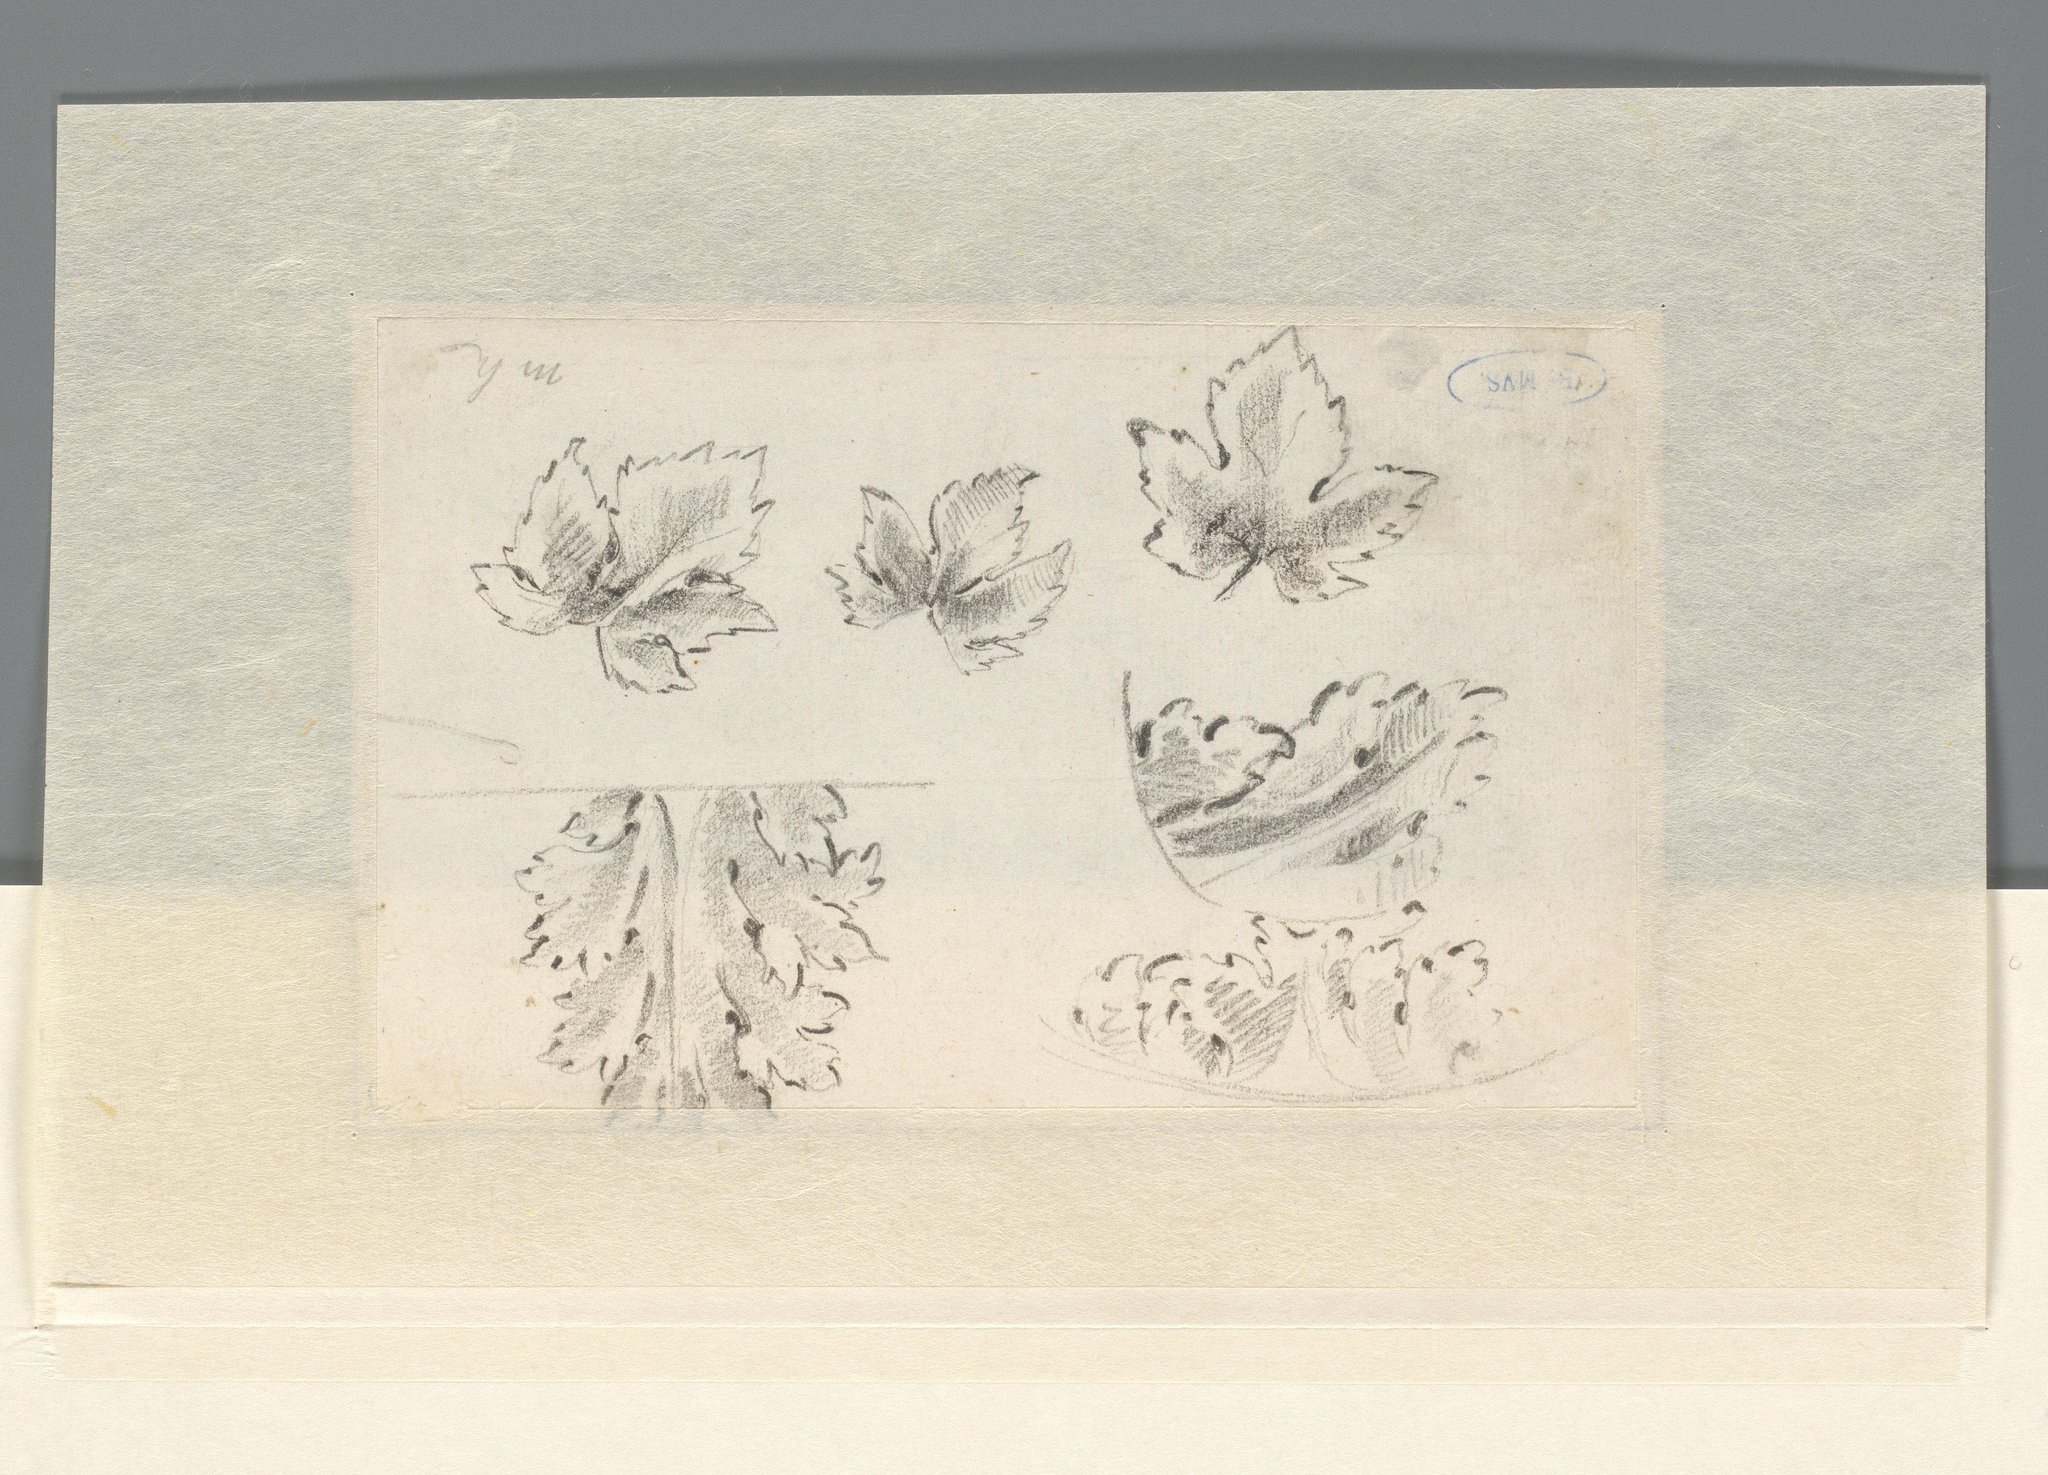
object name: drawing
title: Zes bladstudies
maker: herman saftleven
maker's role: draughtsman, painter, print maker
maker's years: 1609-1685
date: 1619-1685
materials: chalk, paper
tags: plants and herbs (+ leaves, putting forth leaves)